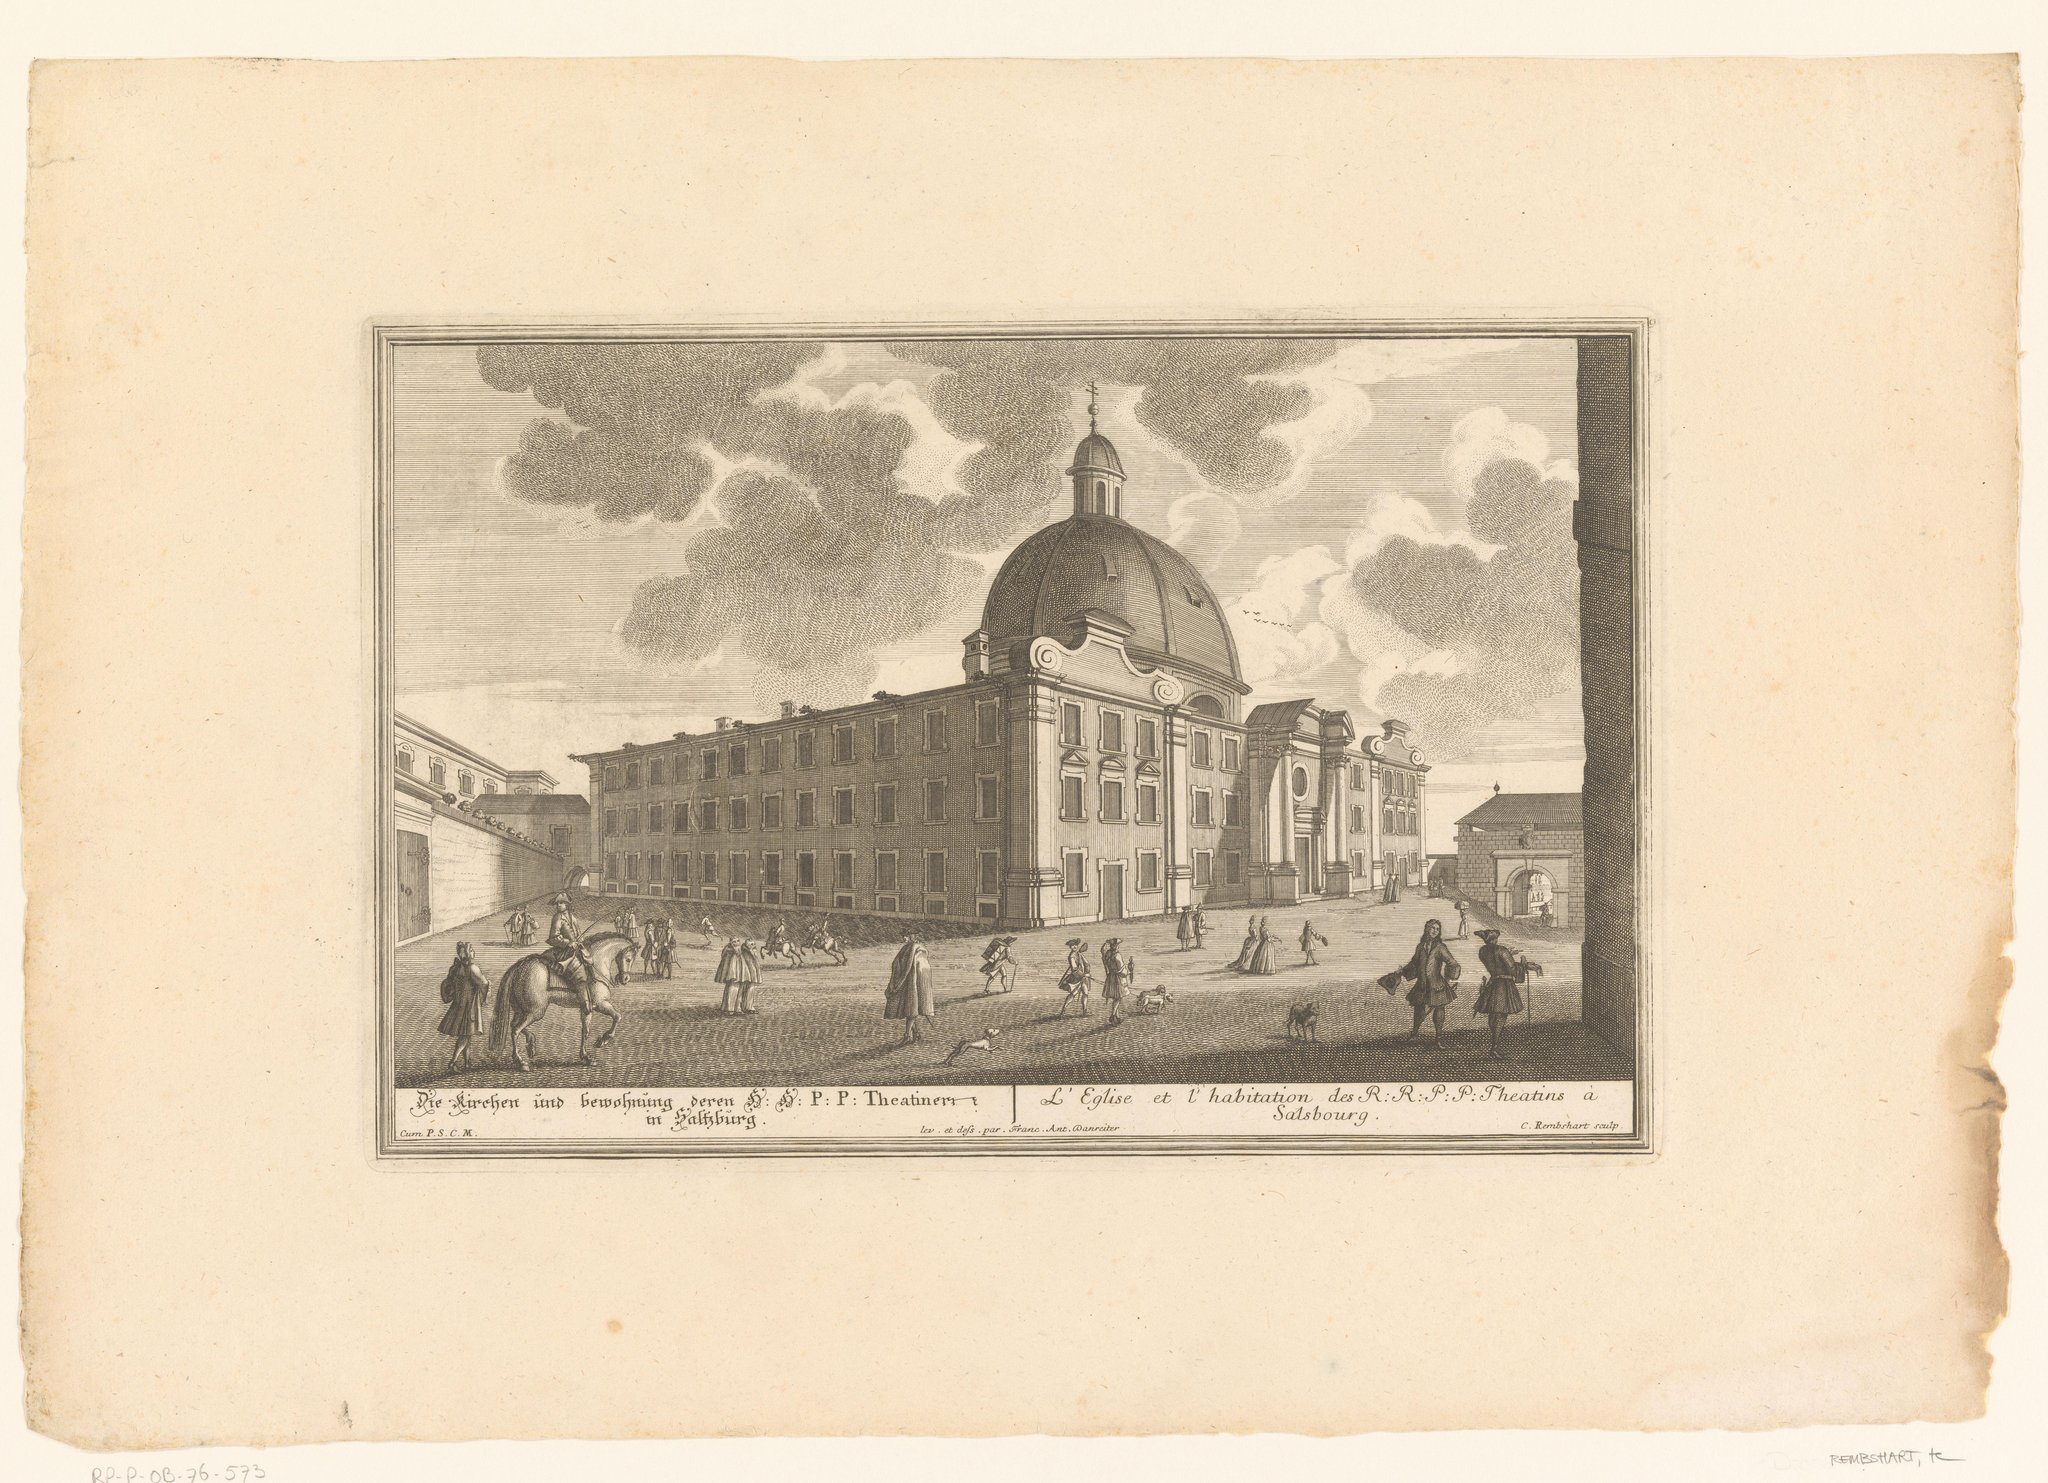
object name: ornament print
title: Die kirchen und bewohnung deren R. R. P. P. Theatiner in Satzburg / L'Eglise et l'habitation des R. R. P. P. Theatins à Salsbourg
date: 1730-1740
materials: paper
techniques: engraving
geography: augsburg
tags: parts of church exterior and annexes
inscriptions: collector's mark: Lugt 2228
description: Façade en zijde van de Kajetanerkerk (Theatinerkerk) en de Kajetanerplatz in Salzburg.